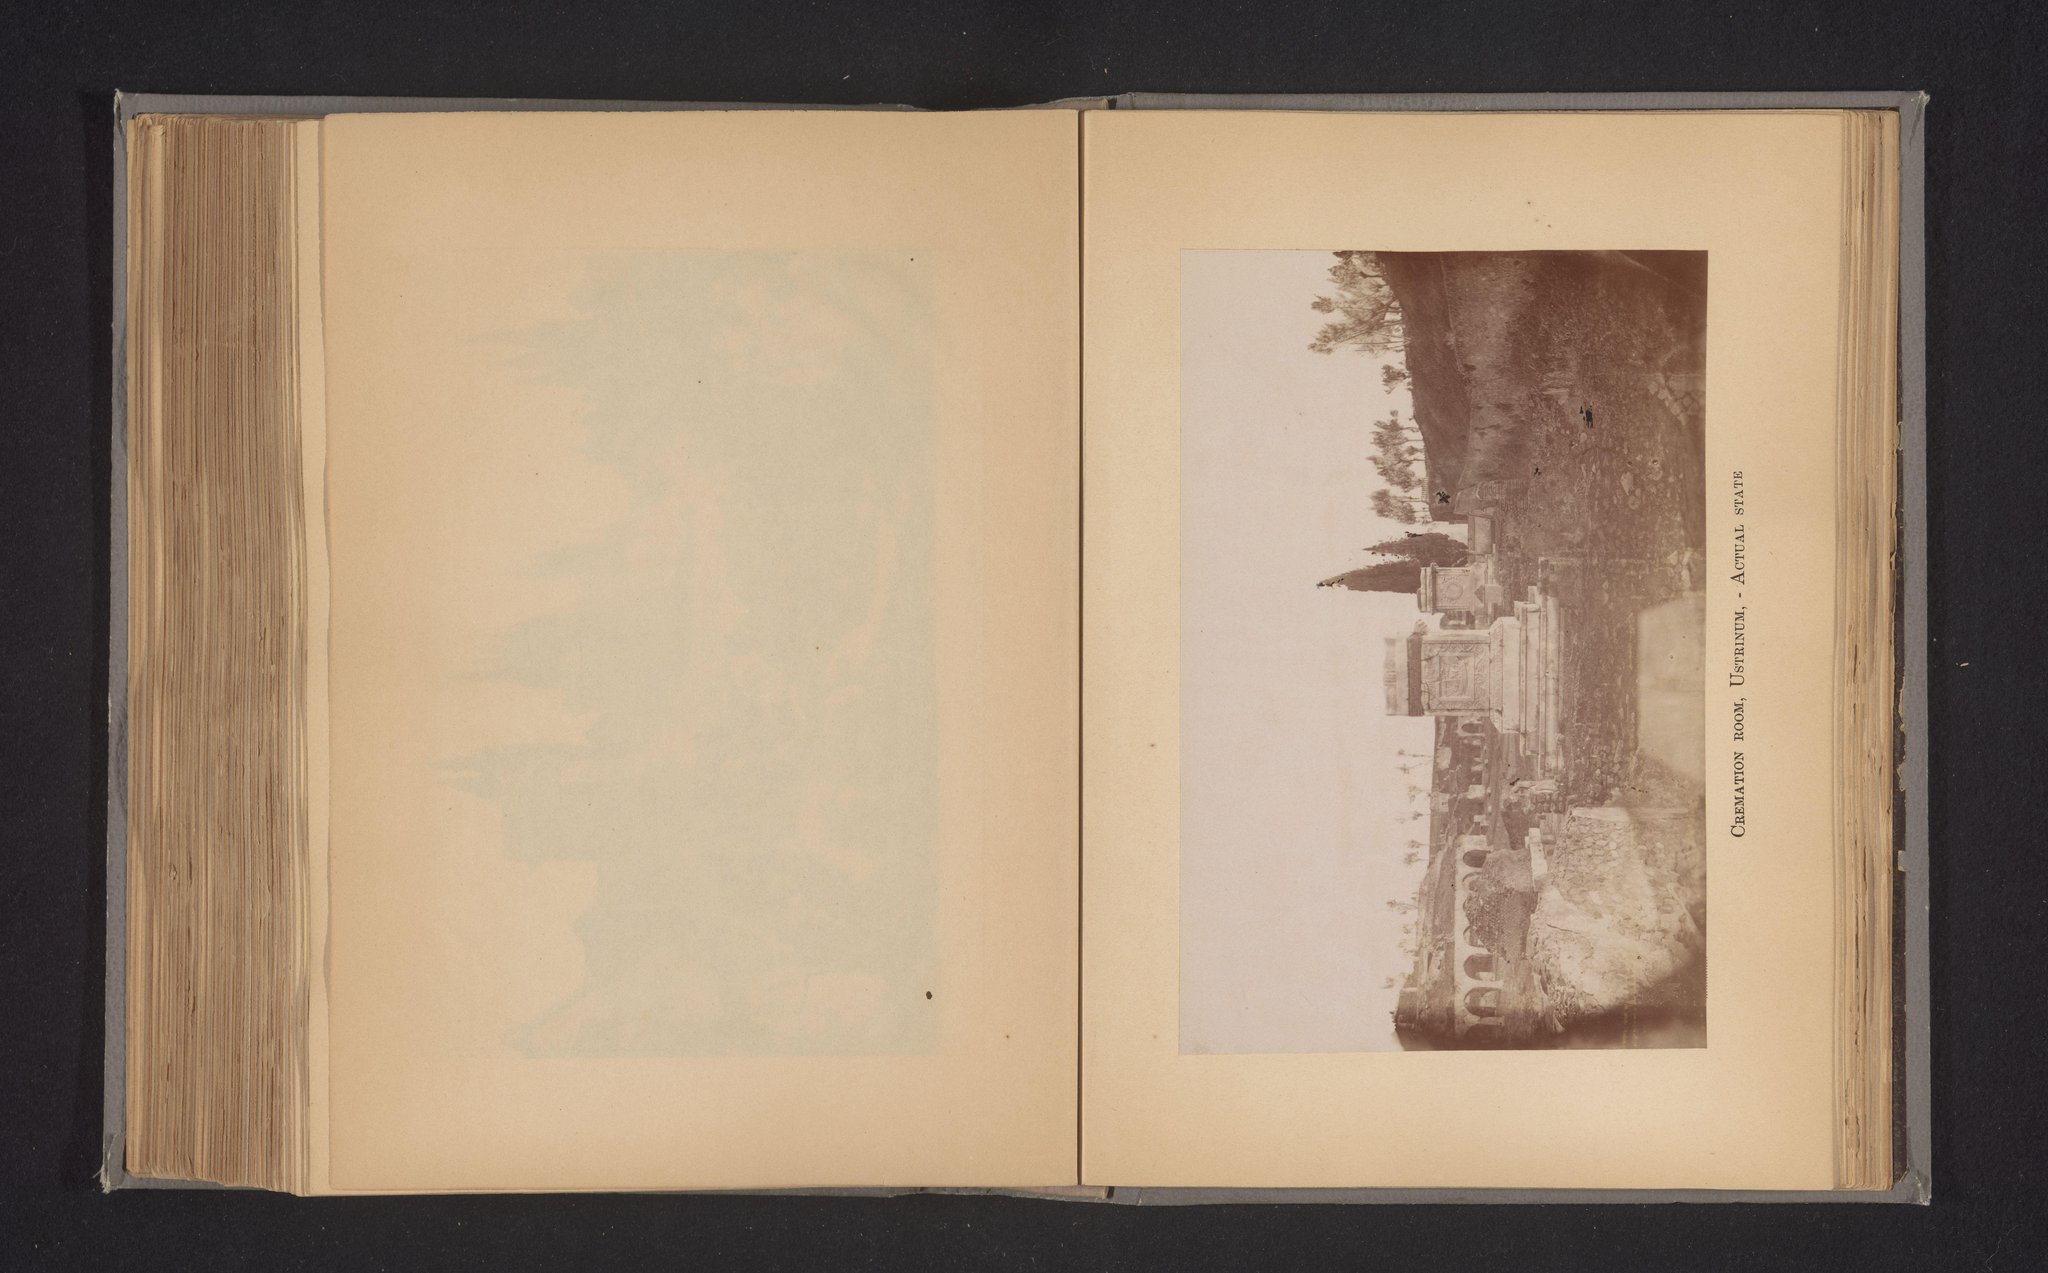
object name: photograph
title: Cremation room, Usterinum - Actual State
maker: Anonymous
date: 1890-1895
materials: photographic support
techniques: albumen print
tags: grave, tomb, street